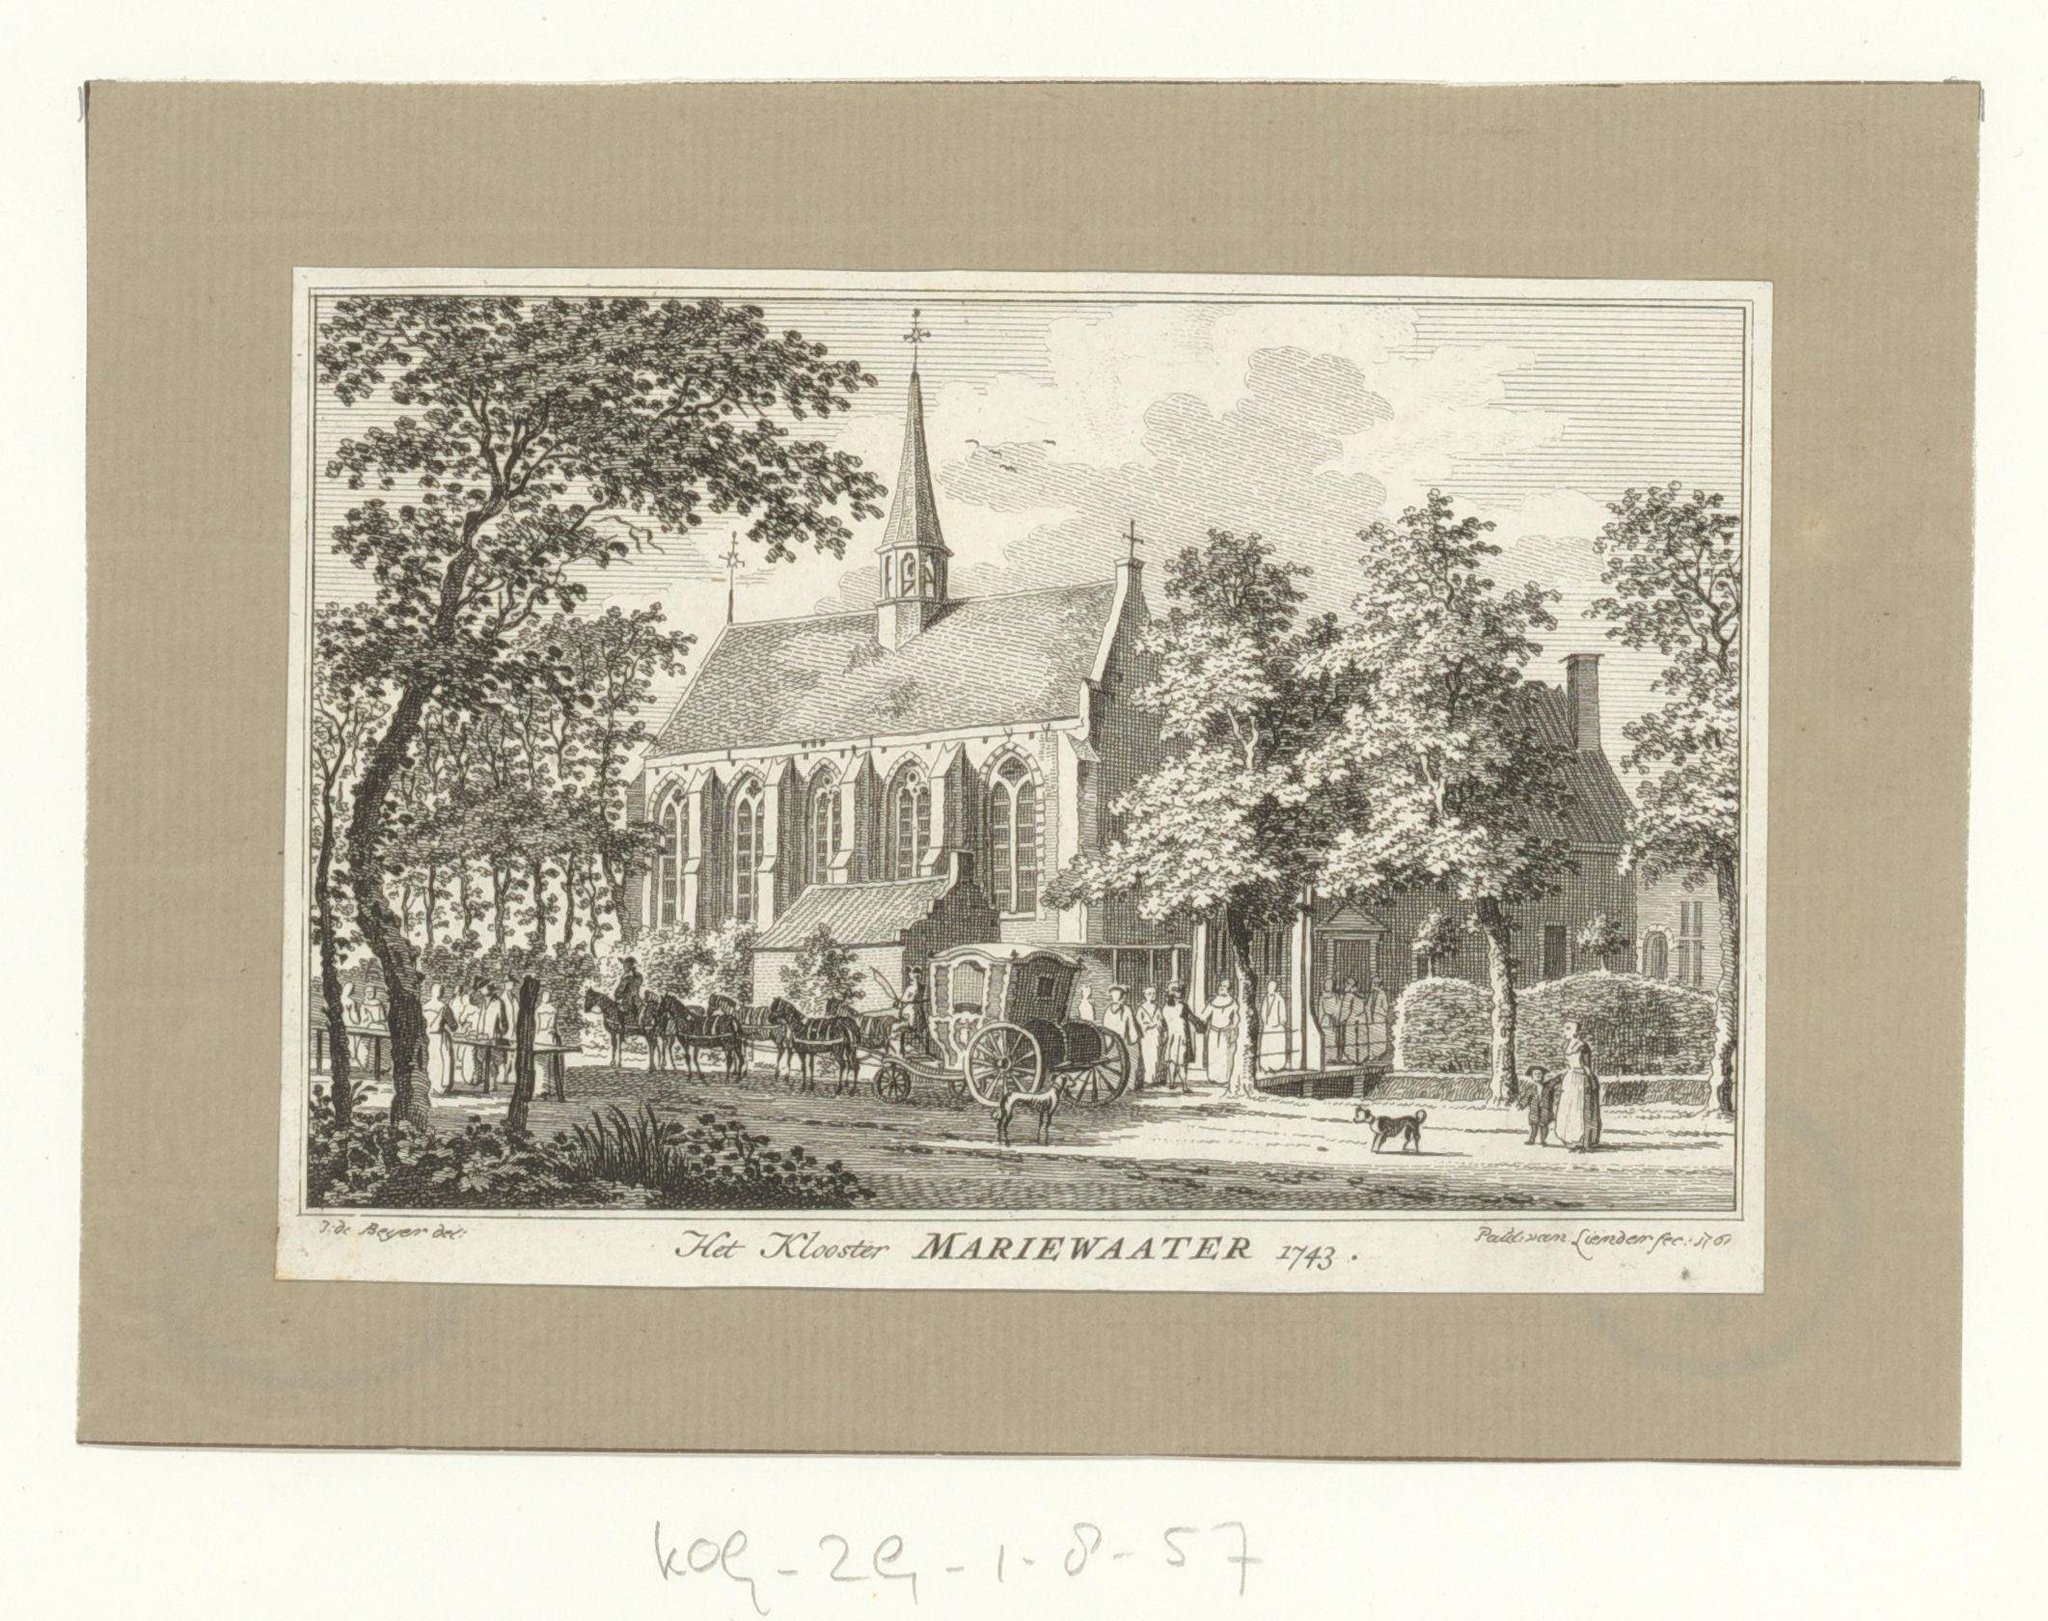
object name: print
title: Het Klooster Mariewaater 1743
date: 1761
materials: paper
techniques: etching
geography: netherlands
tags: abbey, monastery, convent ~ roman catholic church, village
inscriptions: collector's mark, collector's mark: Lugt 1641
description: Gezicht op het klooster Mariënwater in het Duitse Weeze, in het jaar 1743. Onderste helft van een versneden blad waarop oorspronkelijk twee voorstellingen waren gedrukt. Onderwerpsrubrieken binnen de Atlas Zeden en Gewoonten: Kerk en kerkwezen & Armwezen en liefdadige instellingen; Kerkgebouwen elders. F-L.